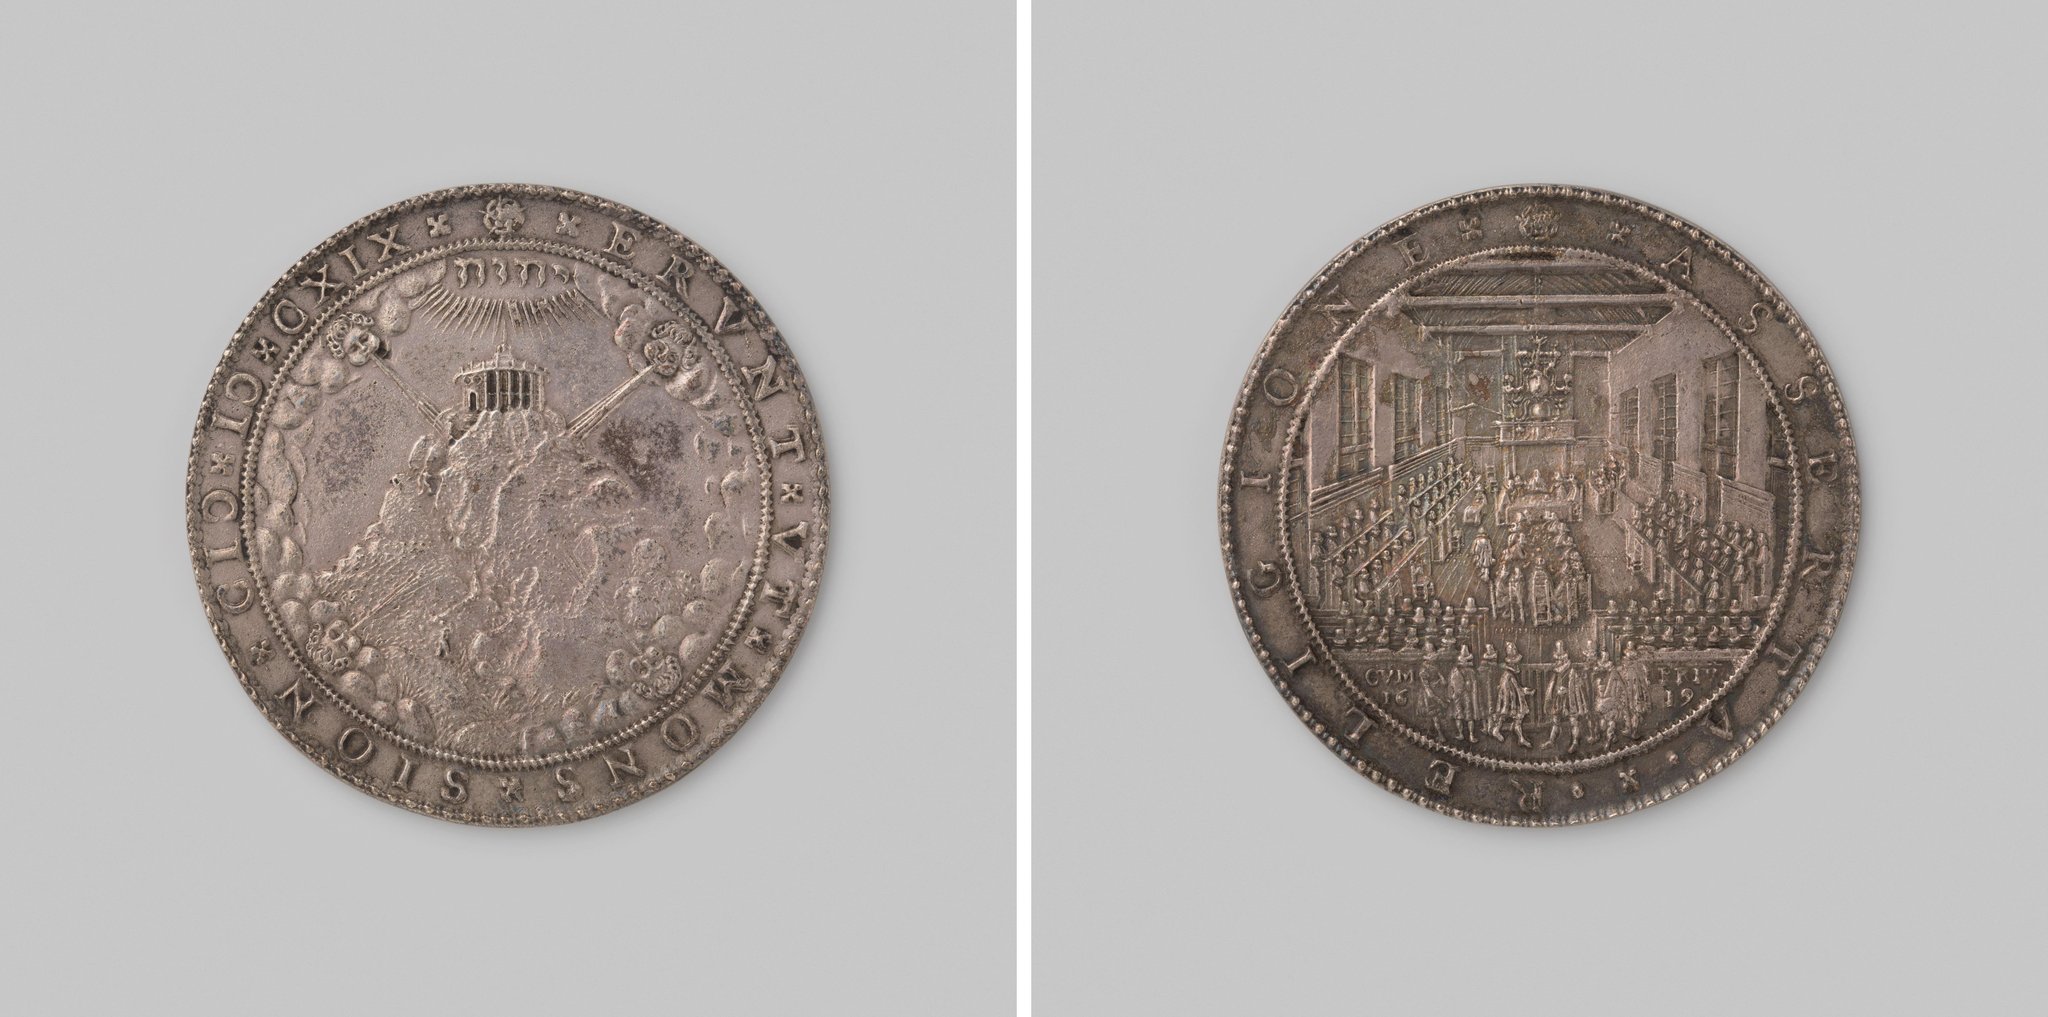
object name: history medal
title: Synode van Dordrecht 1619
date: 1619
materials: silver